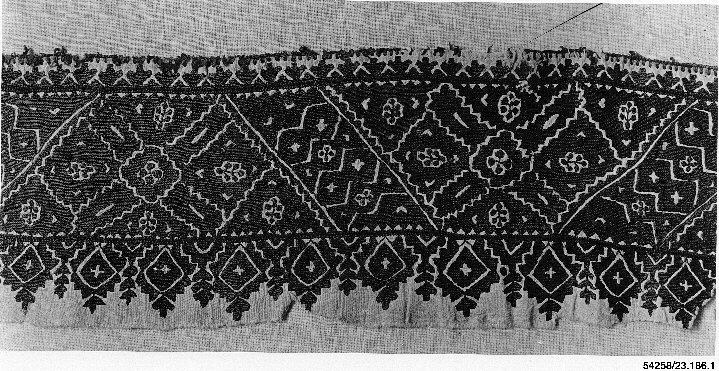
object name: border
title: Border of a Cushion Cover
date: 1801-1833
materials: cotton, silk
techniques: embroidery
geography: morocco